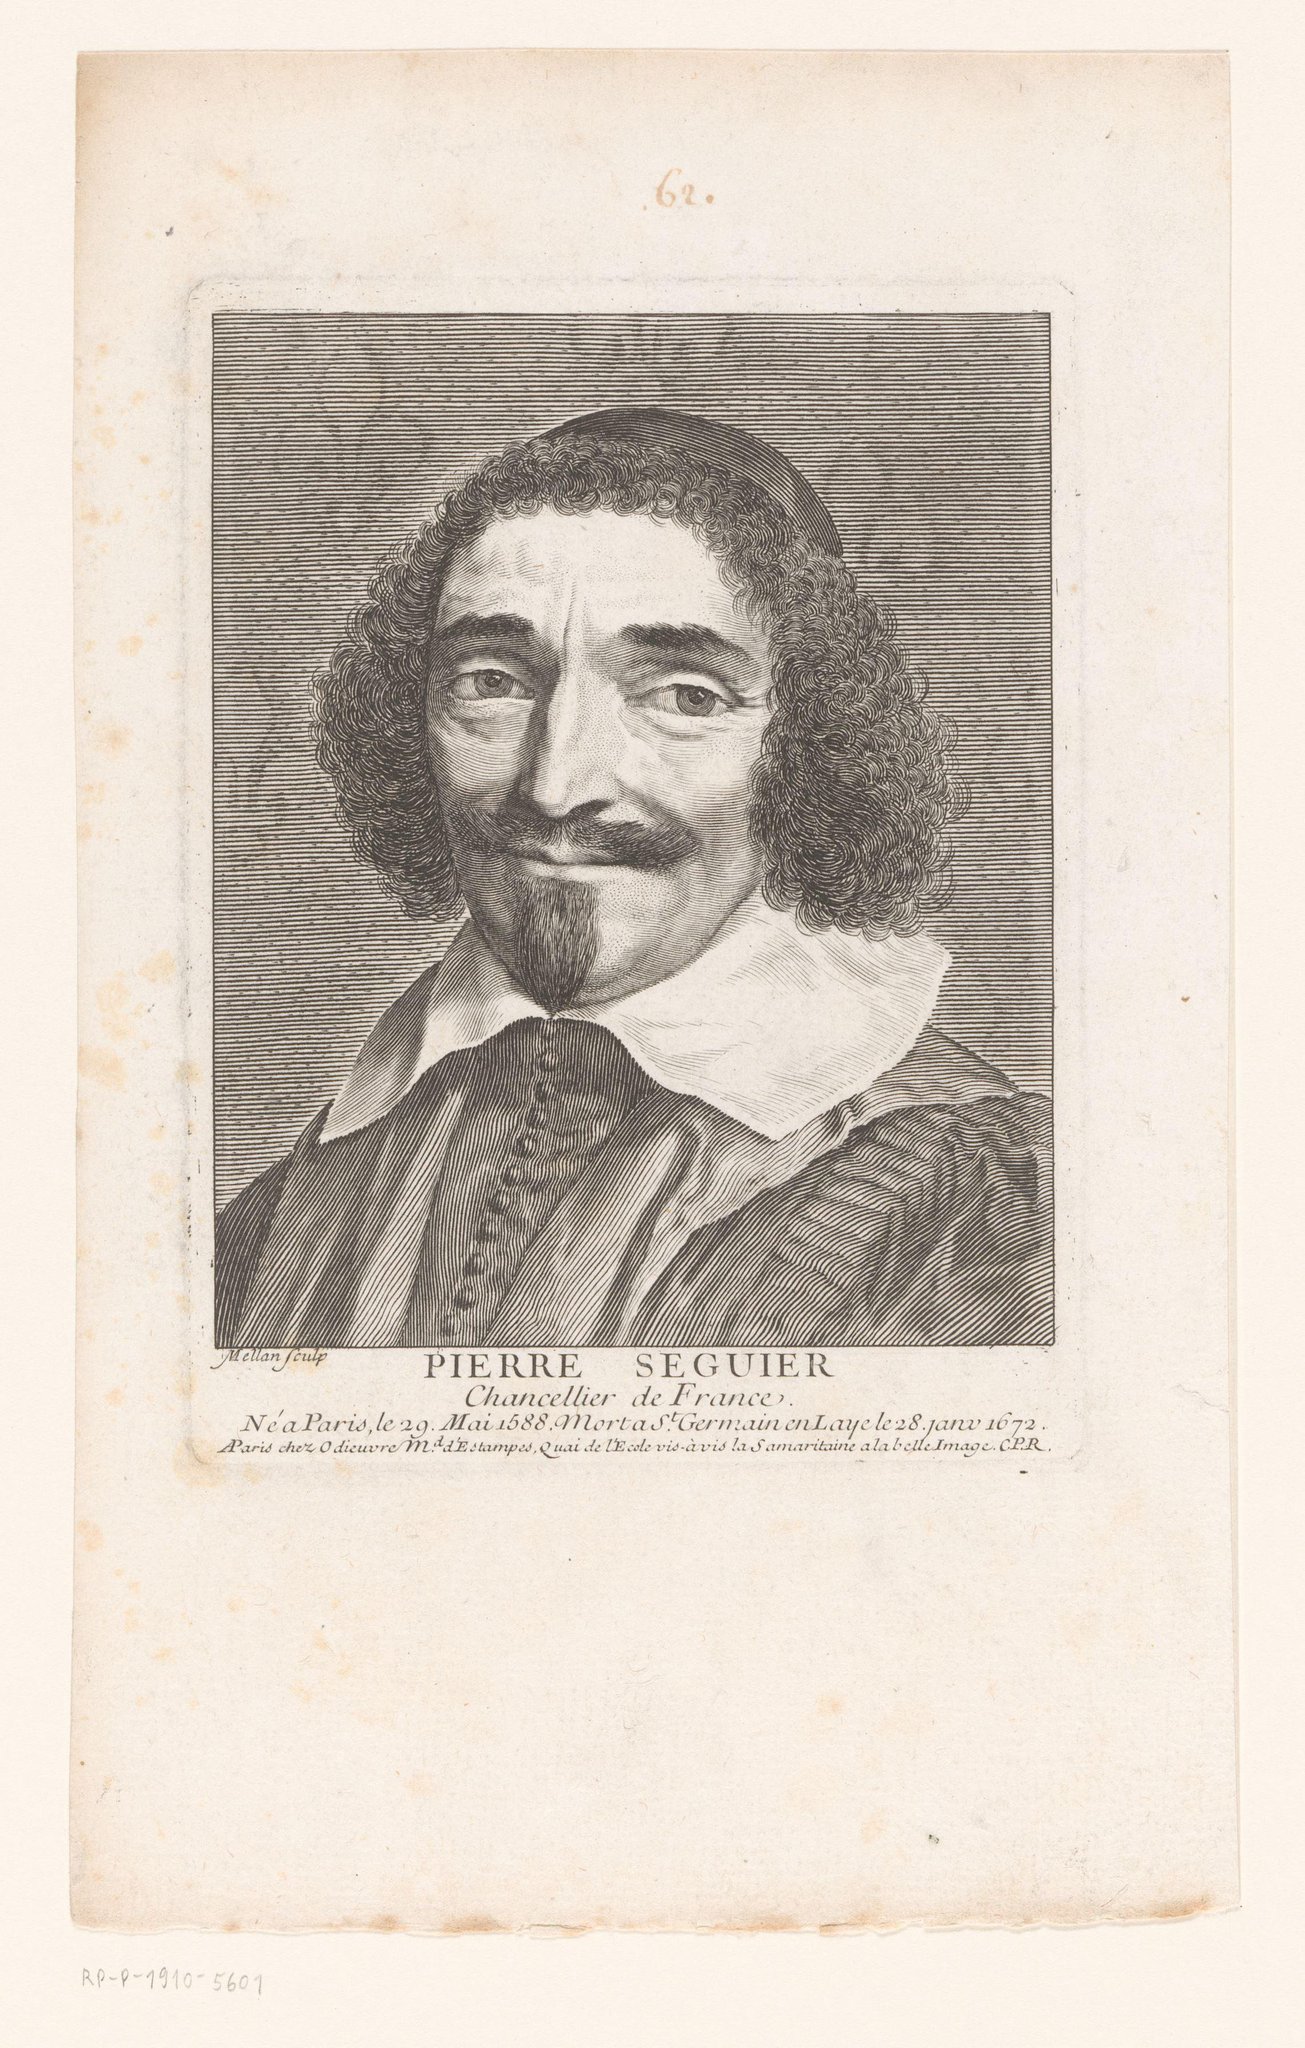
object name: print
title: Portret van Pierre Séguier op 51-jarige leeftijd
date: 1639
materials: paper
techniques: engraving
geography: paris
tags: paris, pierre séguier, historical persons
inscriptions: collector's mark: Lugt 2228, number: ‘62.’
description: Prent uit: Dreux du Radier, Jean-François. L'Europe illustré, contenant l'histoire abregée des souverains, des princes, des prélats, des ministres, (...) en Europe: dans le XVe. siècle compris, jusqu'à présent. Parijs: Michel Odieuvre en Jean-Luc Nyon, 1755-1765, dl. 5.